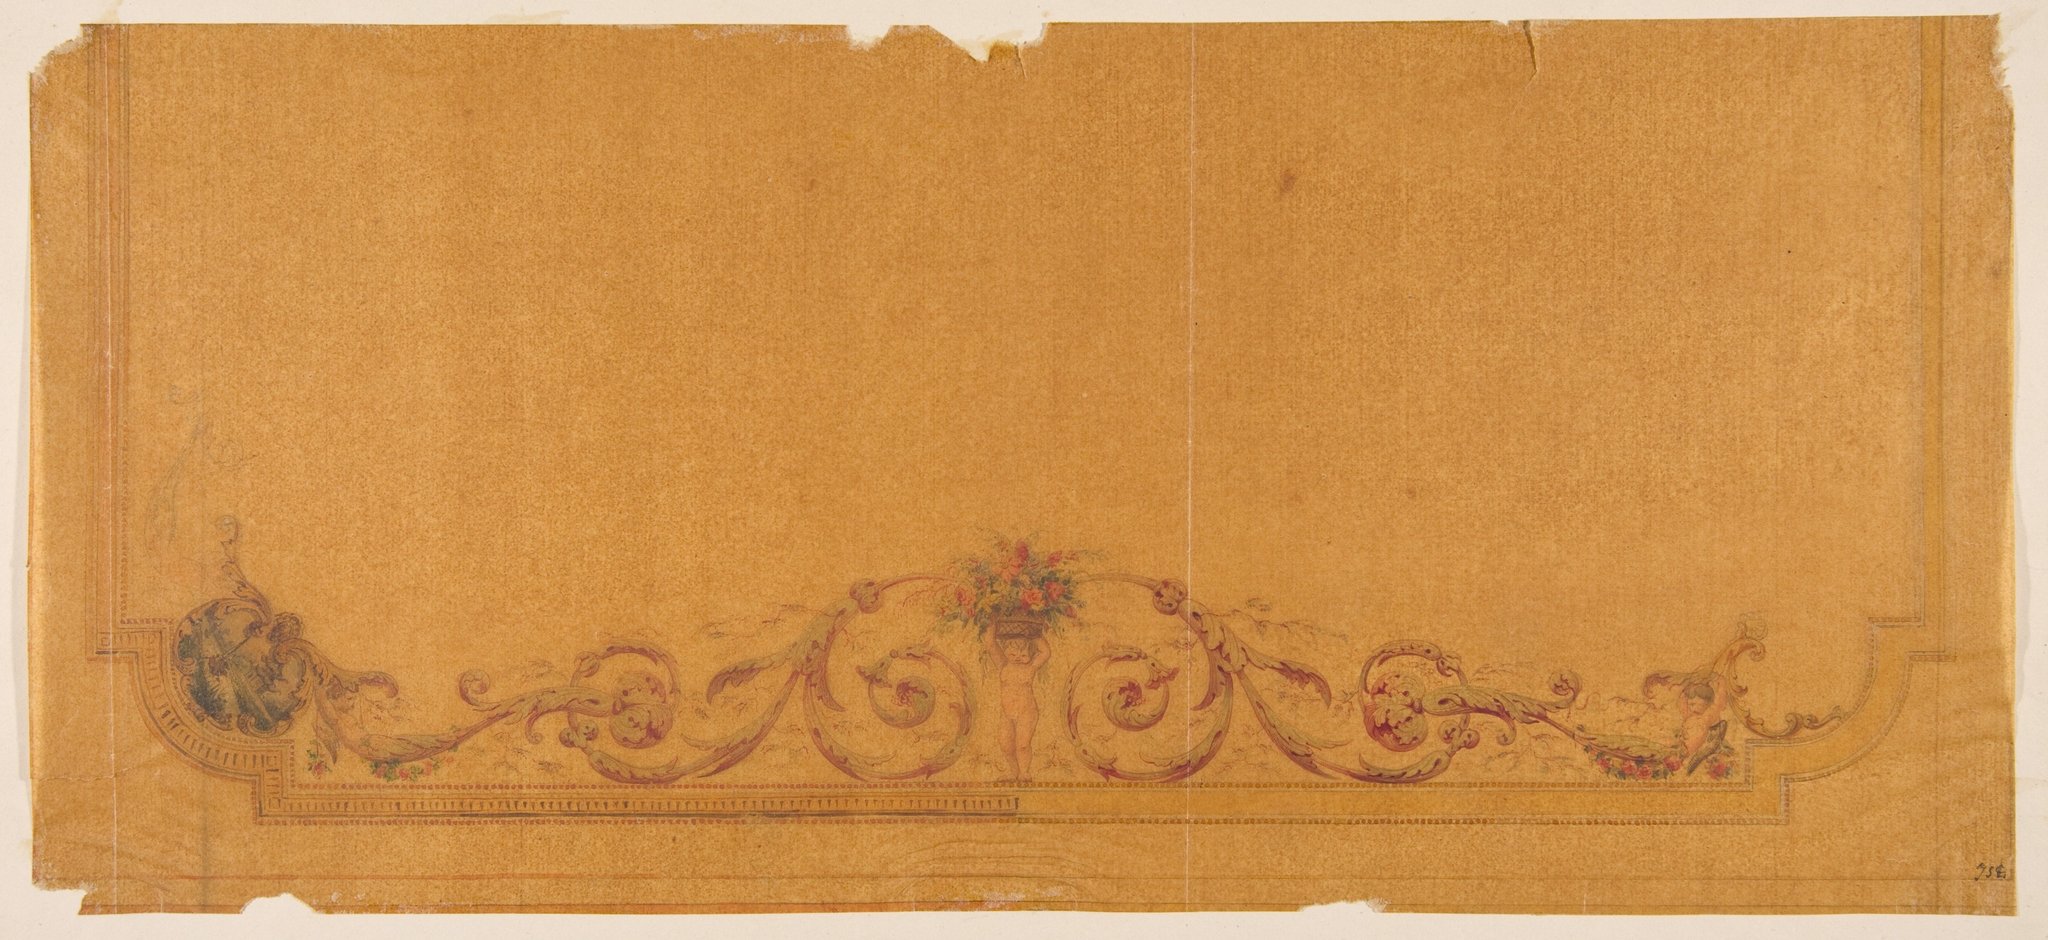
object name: drawing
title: Design for decorative border to a ceiling with a putto carrying a basket of flowers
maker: jules-edmond-charles lachaise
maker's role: artist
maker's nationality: french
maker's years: 1897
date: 1830-1897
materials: cardboard, graphite, watercolor, paper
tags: flowers